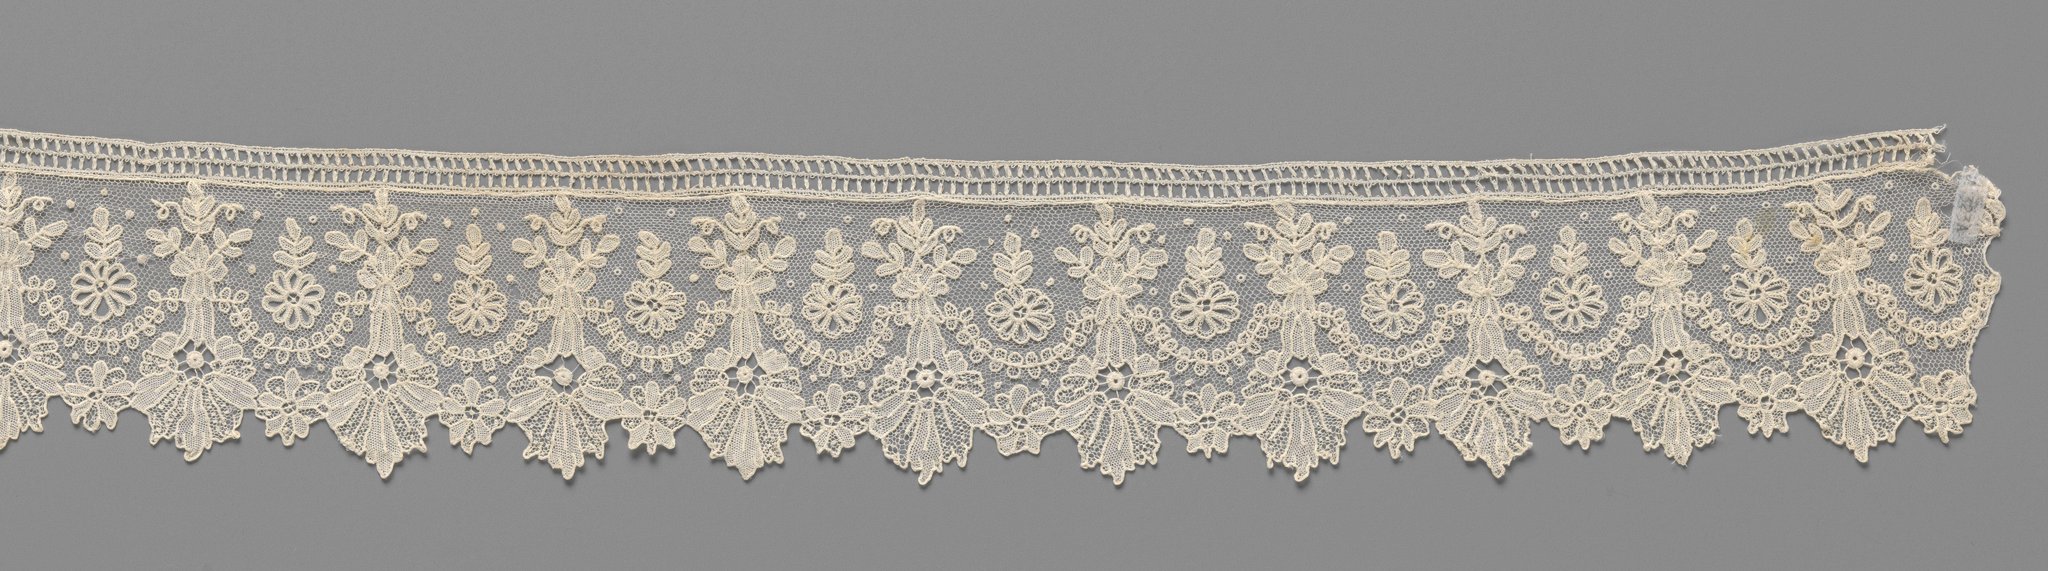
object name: strip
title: Strook naaldkant met hangende klokjesbloem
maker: Anonymous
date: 1850-1875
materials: linen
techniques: lace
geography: brussels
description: Strook naturelkleurige naaldkant: Brusselse gaaskant. Stijf neerhangende grote klokjesbloemen wisselen af met zuiver halfronde slingertjes met een enkel rozetje.